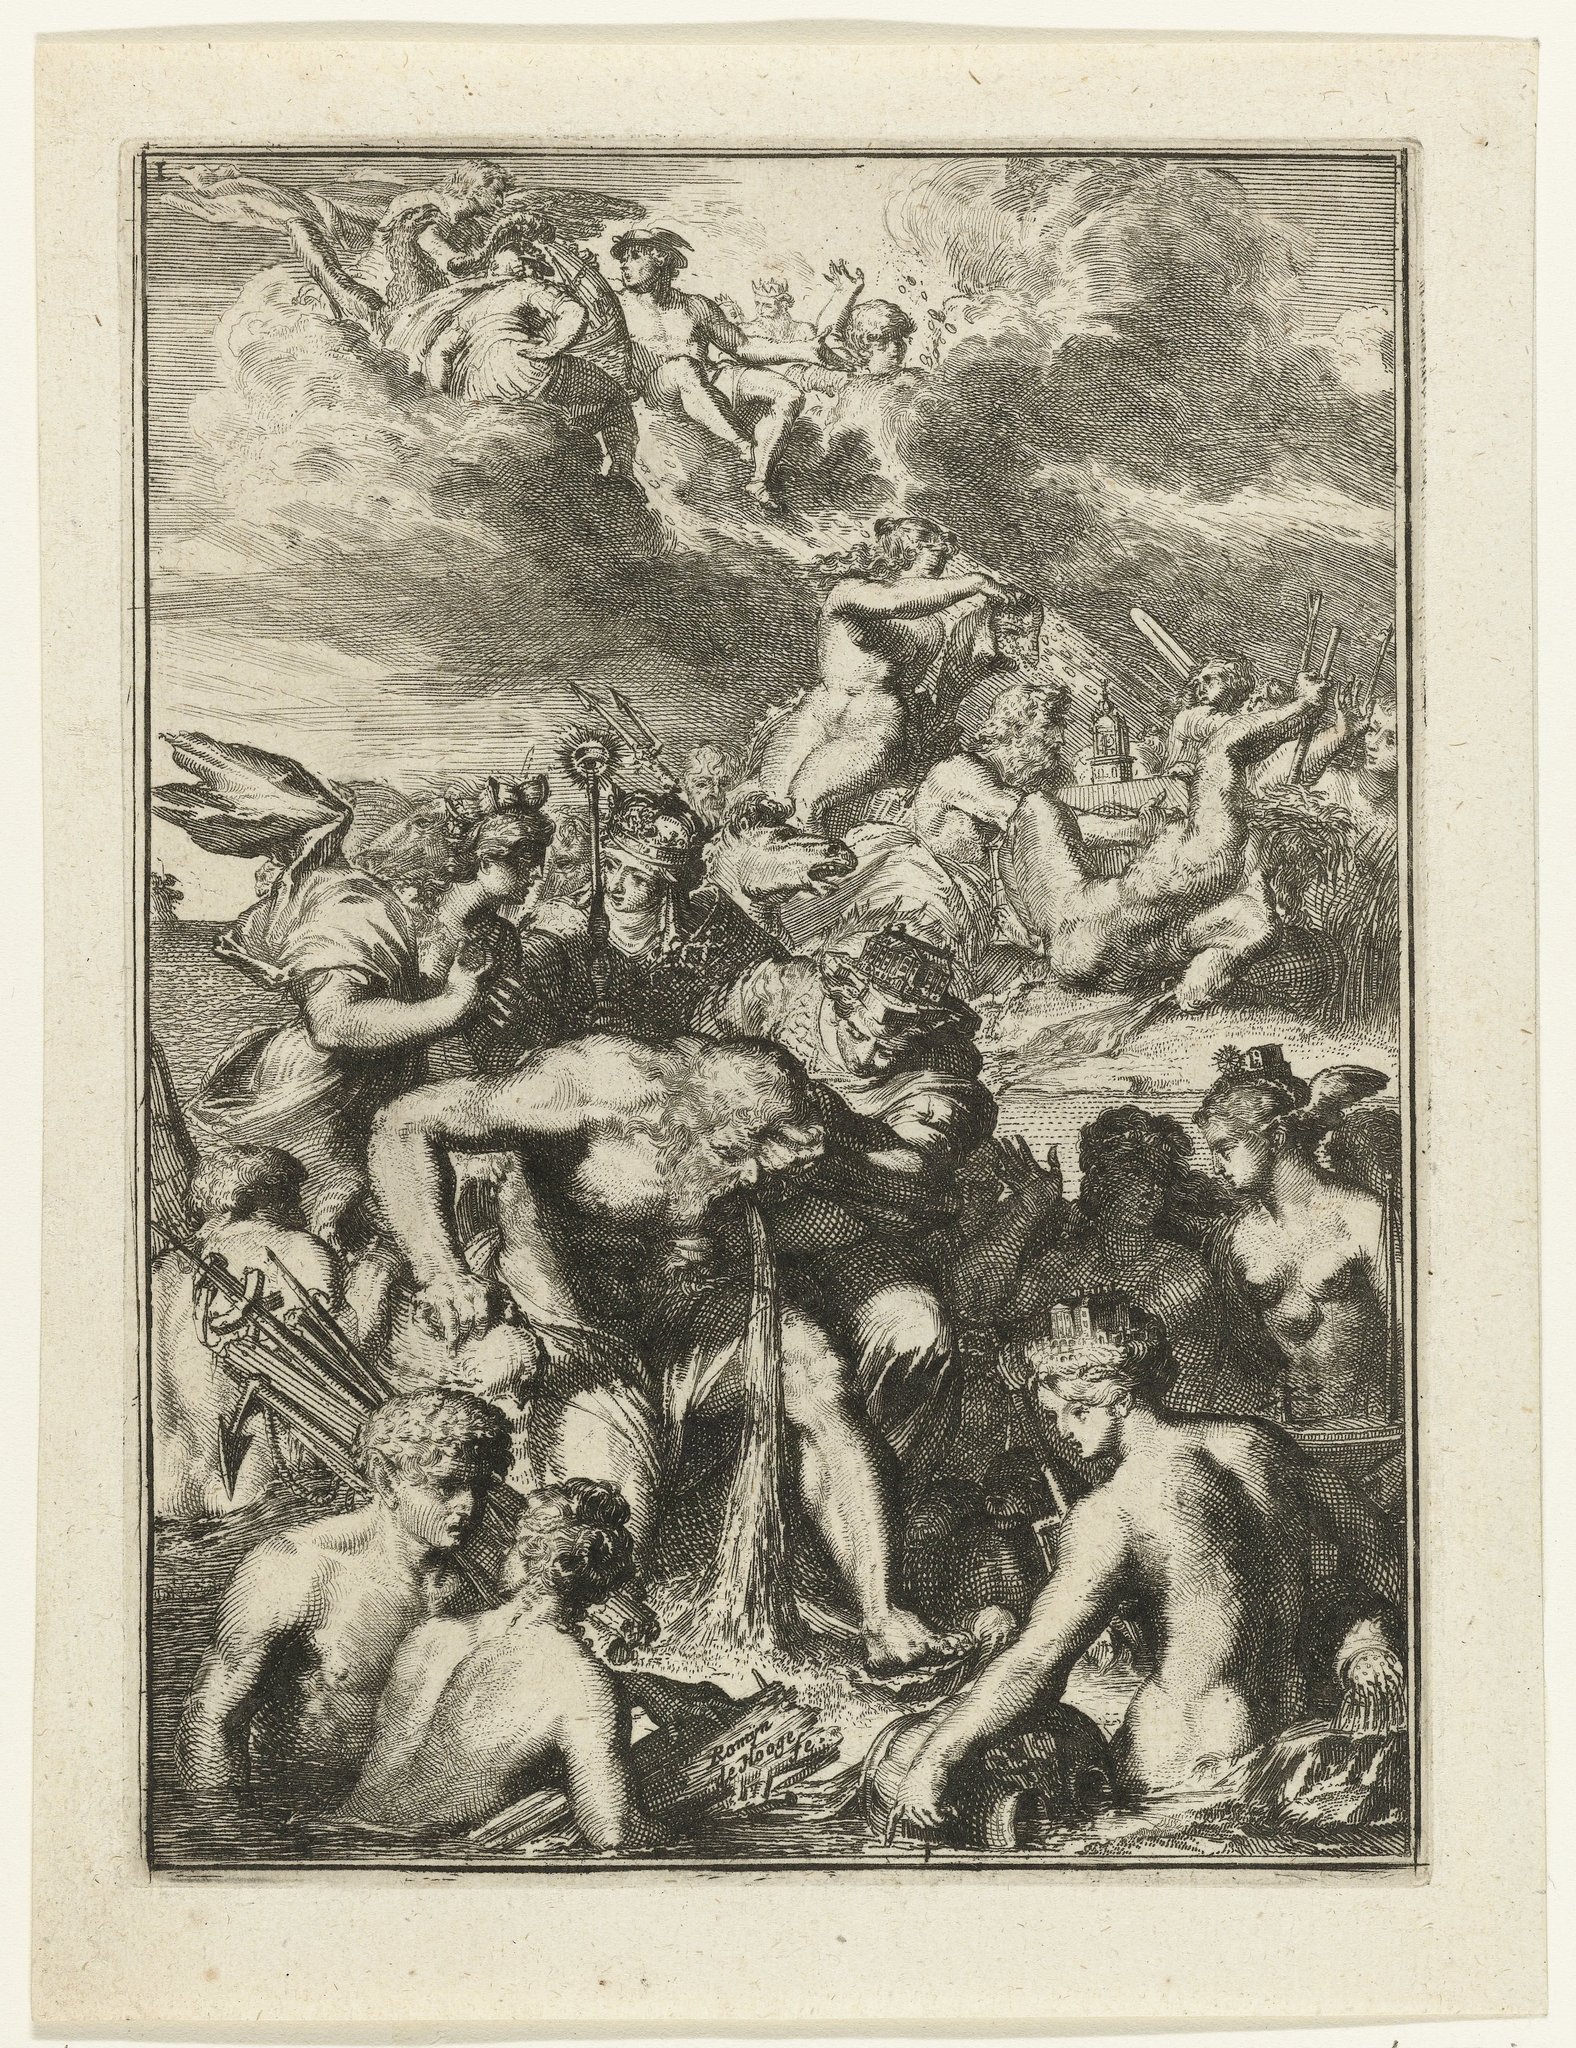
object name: titelprent, frontispice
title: Titelprent van Boek 1 van De Ystroom (1671) van Antonides van der Goes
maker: romeyn de hooghe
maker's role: draughtsman, goldsmith, painter, print maker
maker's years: 1645-1708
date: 1671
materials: paper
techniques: engraving, etching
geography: netherlands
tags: (story of) mercury (hermes), river personified, 'fiumi' (ripa), gods of the waters: neptune and his environment, vomiting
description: Titelprent van Boek 1 van De Ystroom (1671) van Antonides van der Goes. Allegorische voorstelling met de Ystroomgod in het midden die slijm en veen uitspuugt. Hij wordt omringd door personificaties van onder andere de vestingbouwkunst, de muur, de zeevaart, de wakkerheid, de Zuiderzee, de moddermolen. Op de achtergrond rechts Neptunus en de personificatie van de Amstel. In de lucht Mercurius, Ganimedes en Minerva.